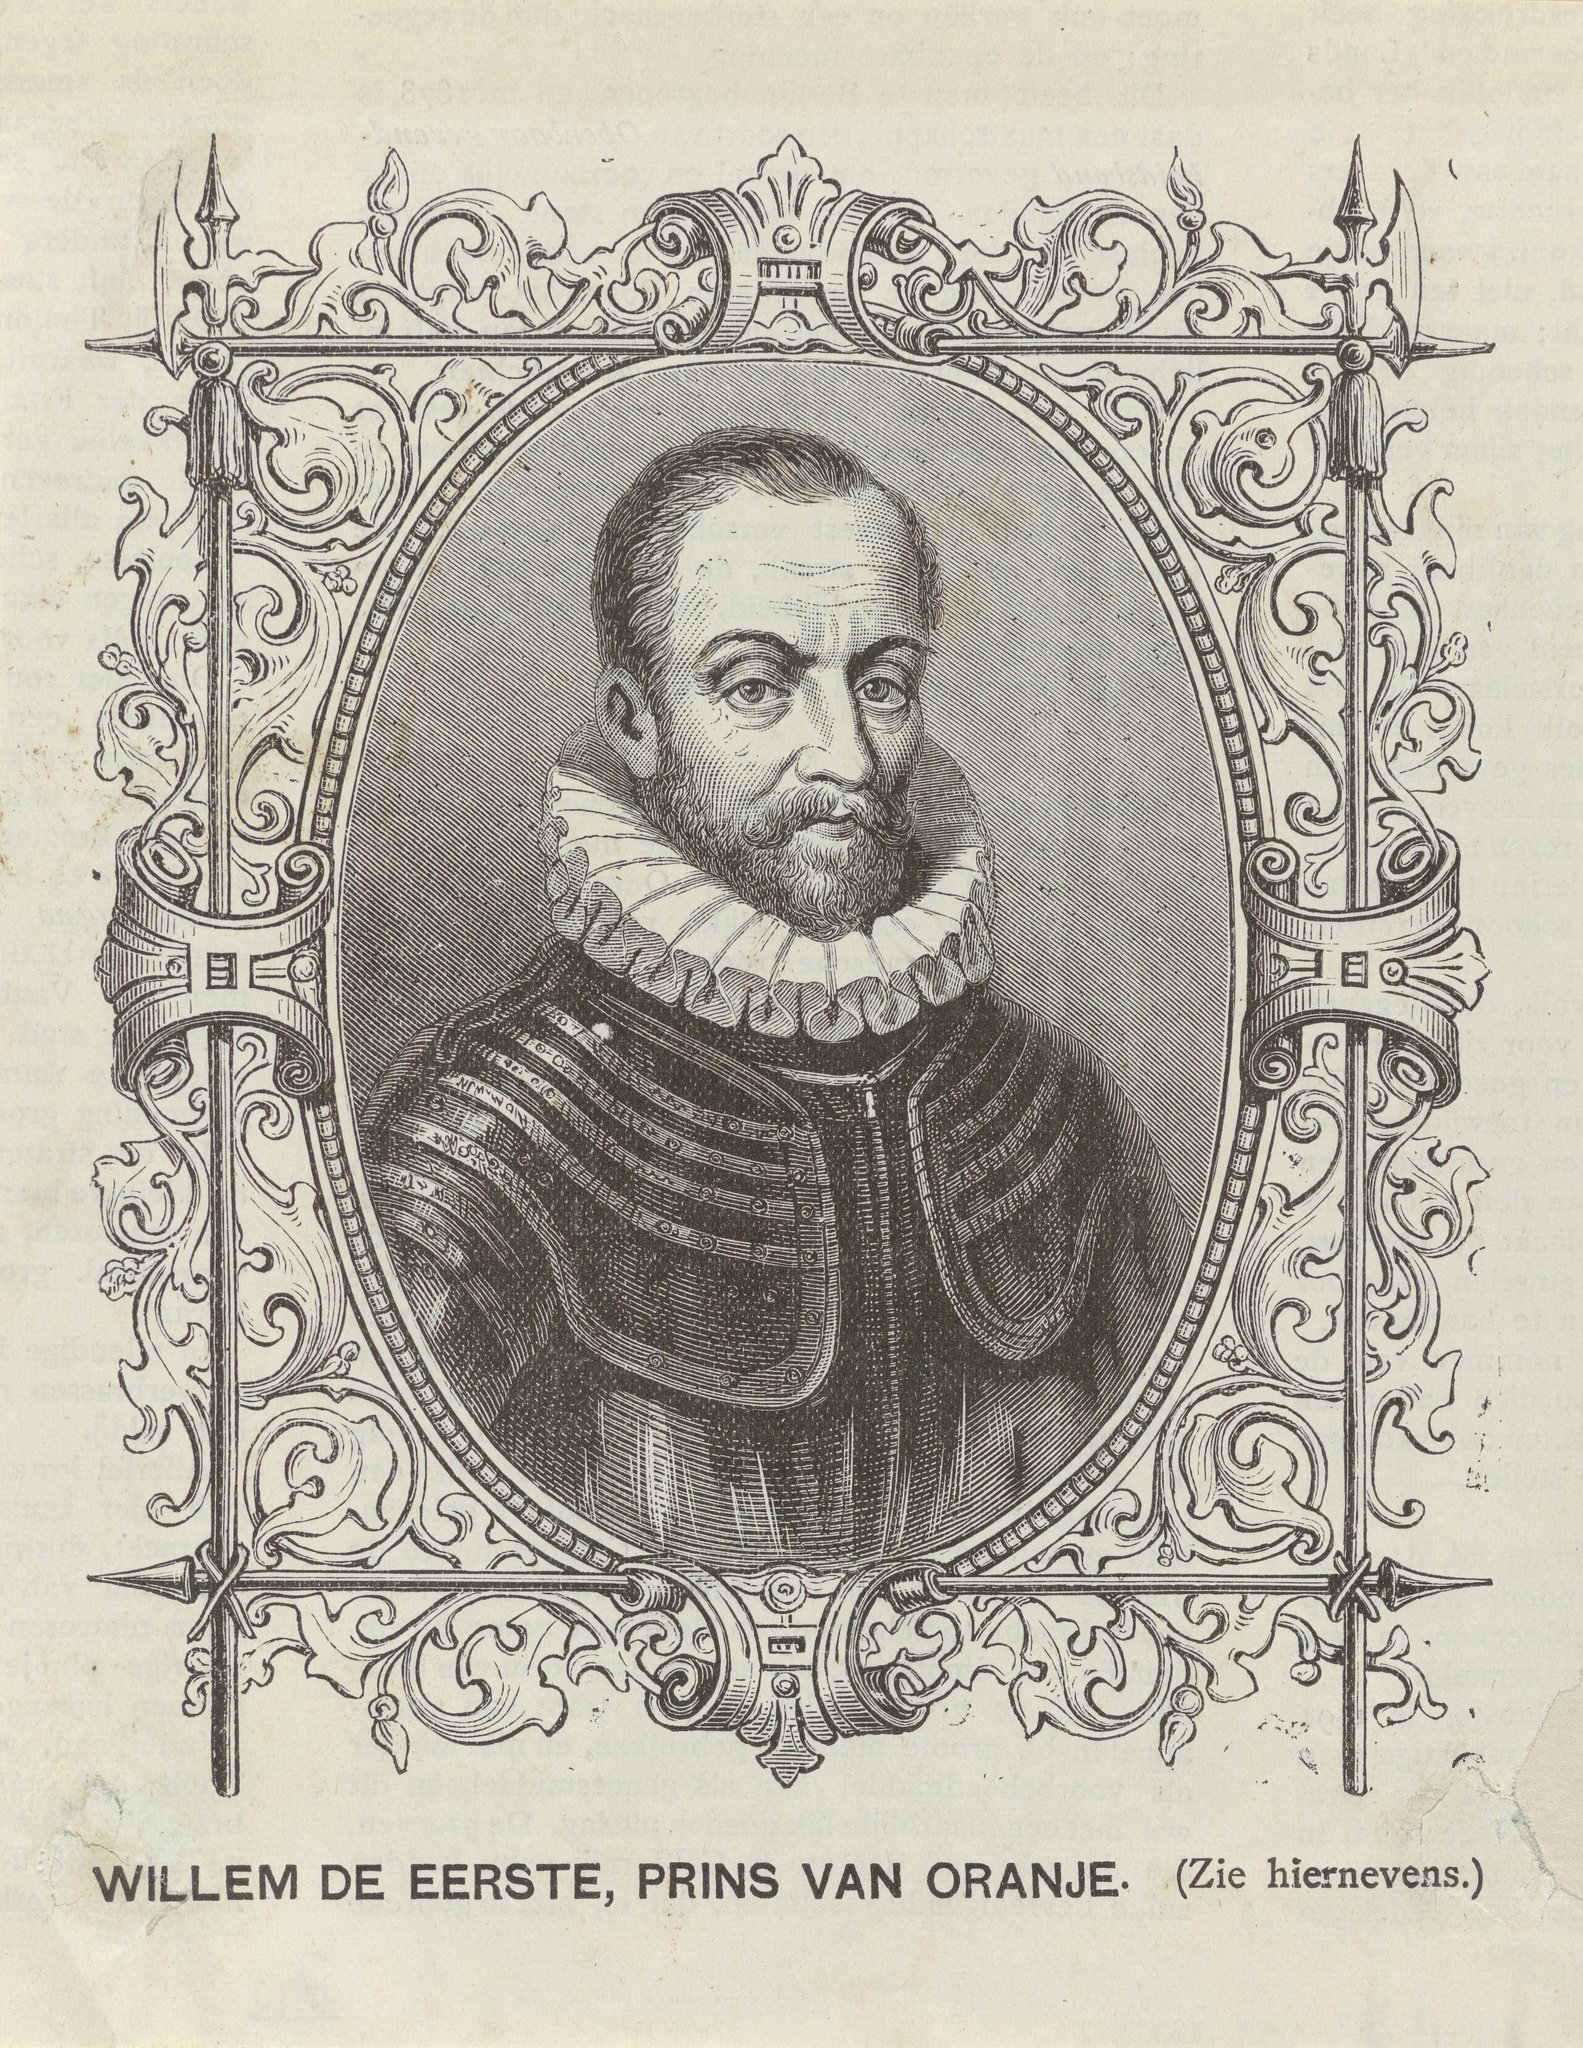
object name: book illustration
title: Portret van Willem I, prins van Oranje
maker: Anonymous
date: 1800-1899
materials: paper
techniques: letterpress printing, engraving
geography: low countries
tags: delft, william i (prince of orange)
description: De hier vermelde titel verwijst naar de hoogst verkregen titel van de geportretteerde, niet per se naar de titel die de geportretteerde op deze voorstelling draagt.